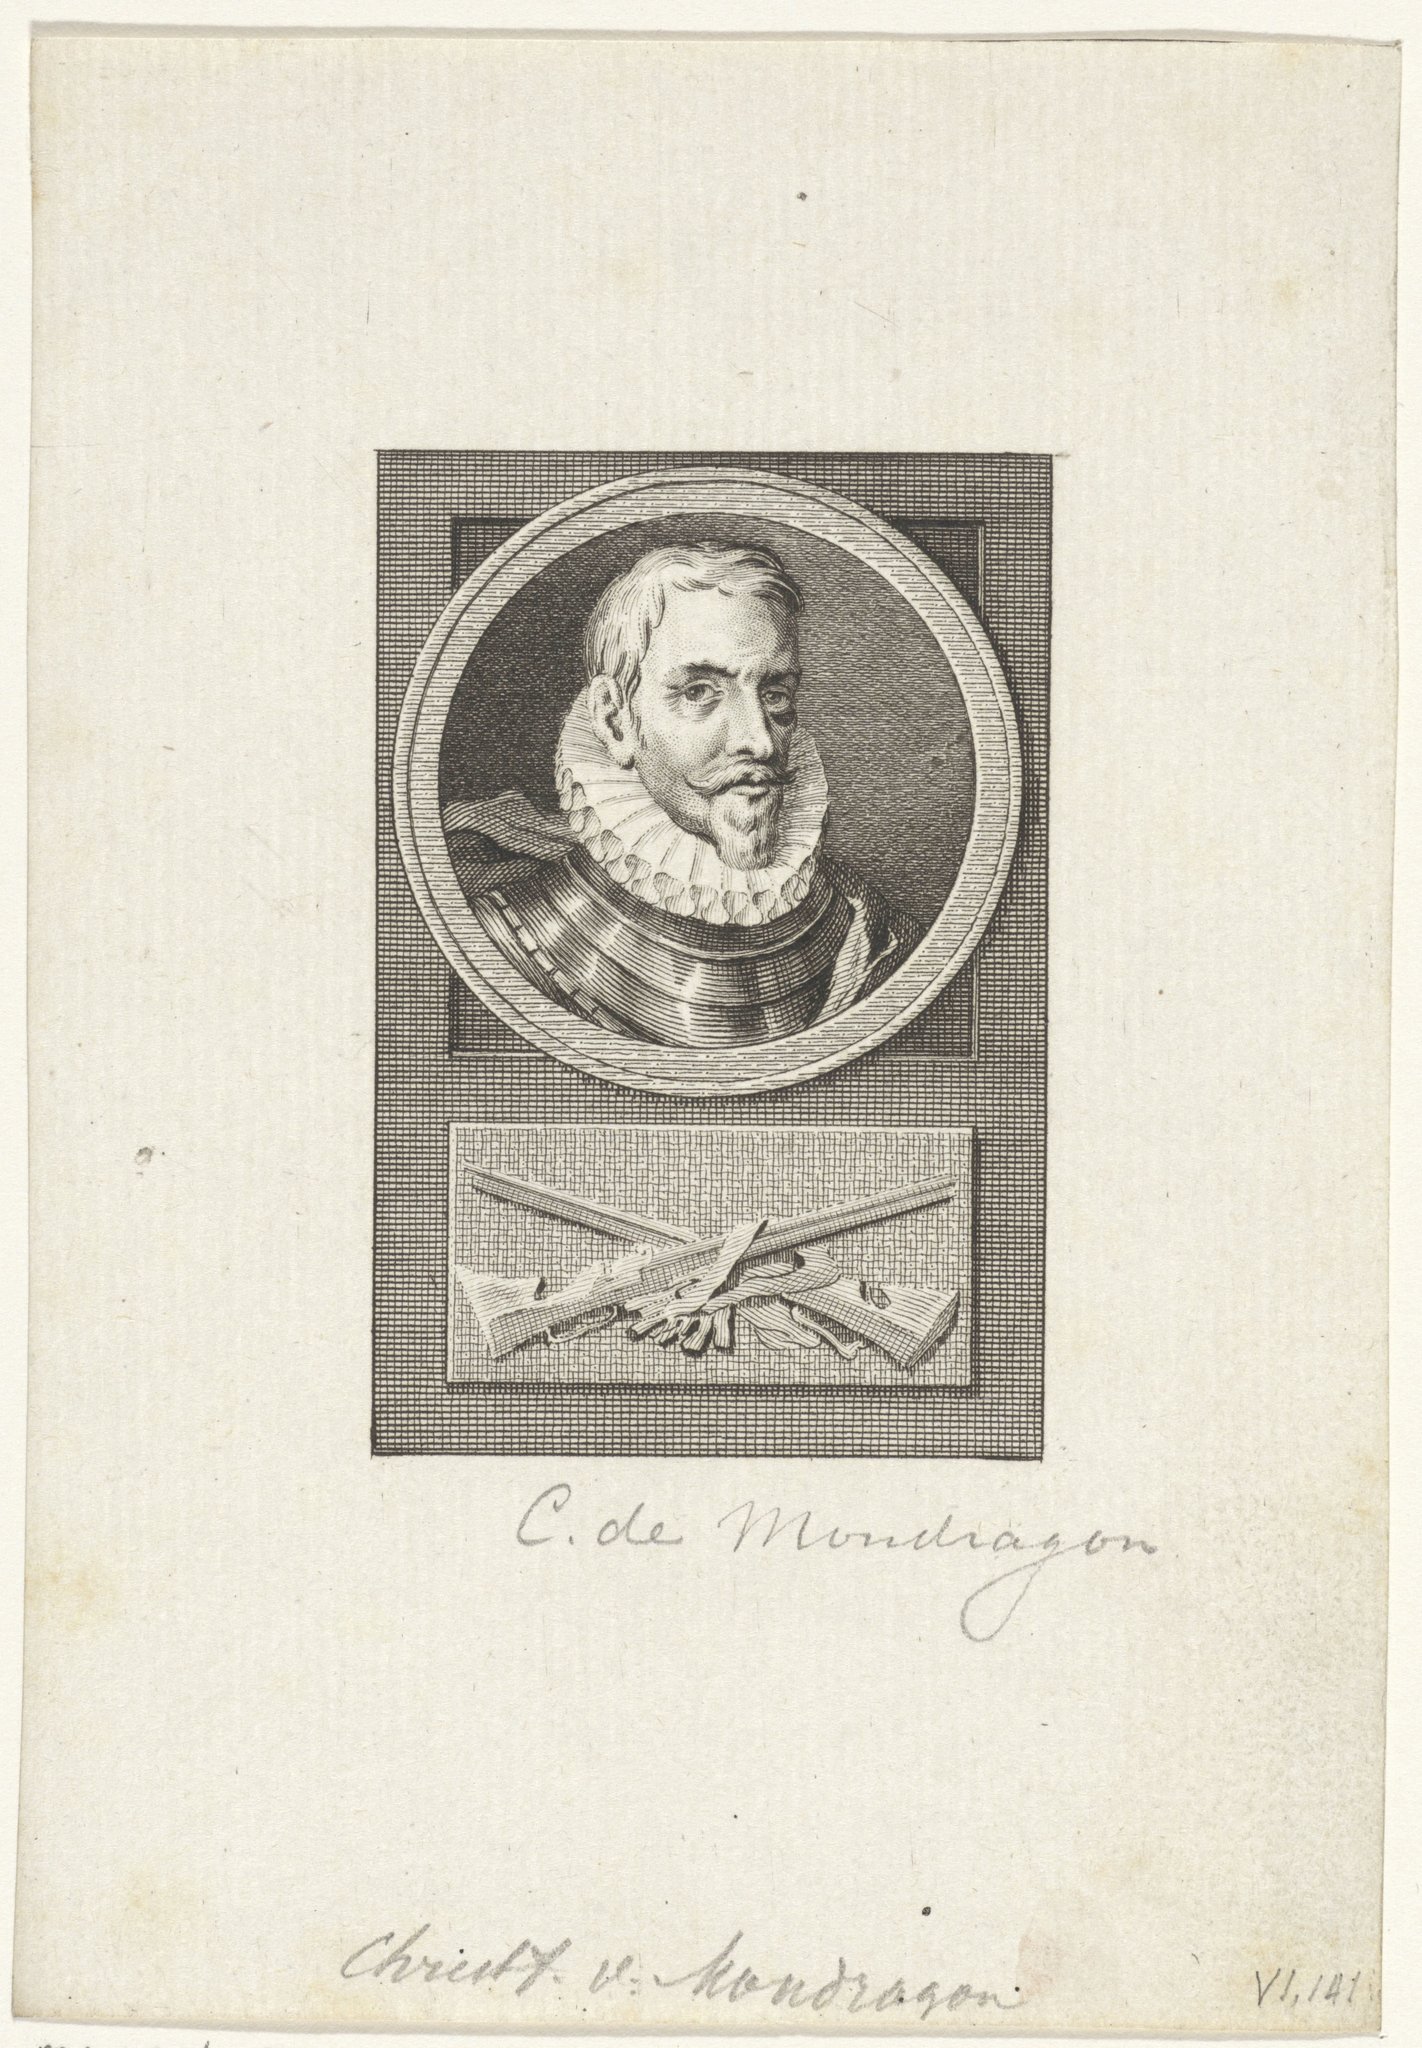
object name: print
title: Portret van Cristóbal de Mondragón y Otalora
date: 1783-1795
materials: paper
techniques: engraving, etching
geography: amsterdam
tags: antwerp, firearms: rifle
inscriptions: collector's mark: Lugt 2228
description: Latere staat prent gebruikt in: Fokke, Jan. Geschiedenissen der Vereenigde Nederlanden voor de vaderlandsche jeugd Ie-XXVste deel. Amsterdam: Johannes Allart, 1783-1795. Deel VI.